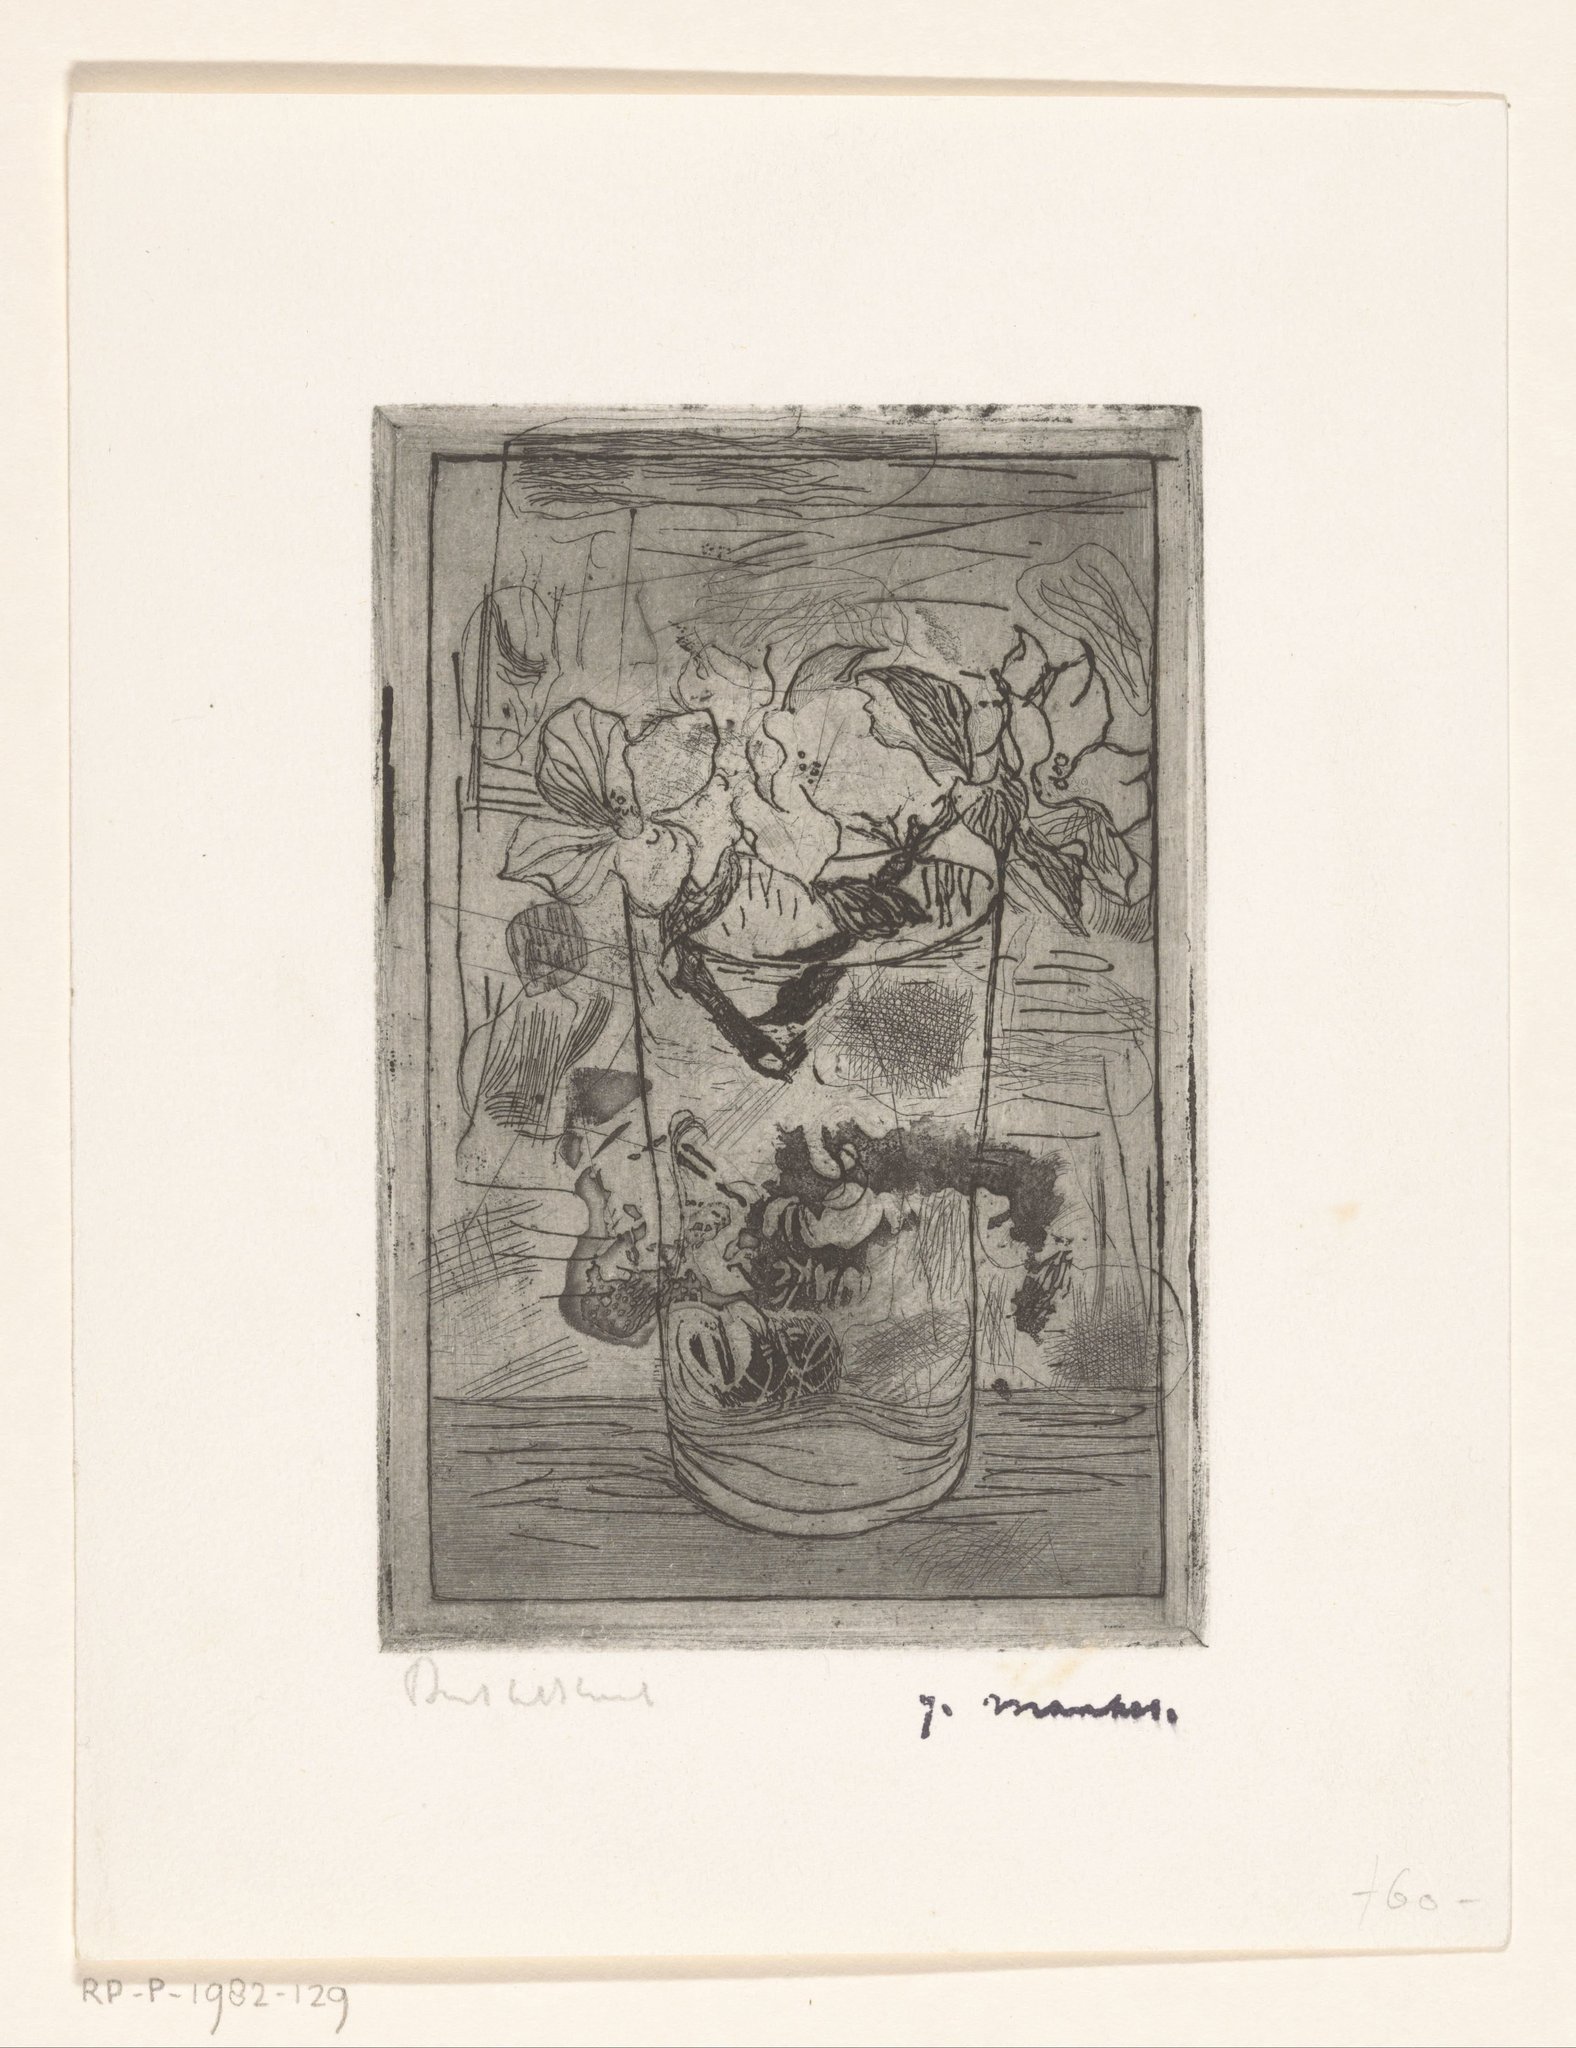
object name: print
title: Glas met bloesemtakken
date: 1913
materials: paper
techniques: etching, intaglio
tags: flowers, container of glass: bottle, jar, vase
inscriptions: collector's mark: Lugt 2228, collector's mark: Lugt 2760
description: In 1968 vervaardigde Kuik op verzoek van de familie Mankes in beperkte oplage nadrukken van drukvormen van Mankes.